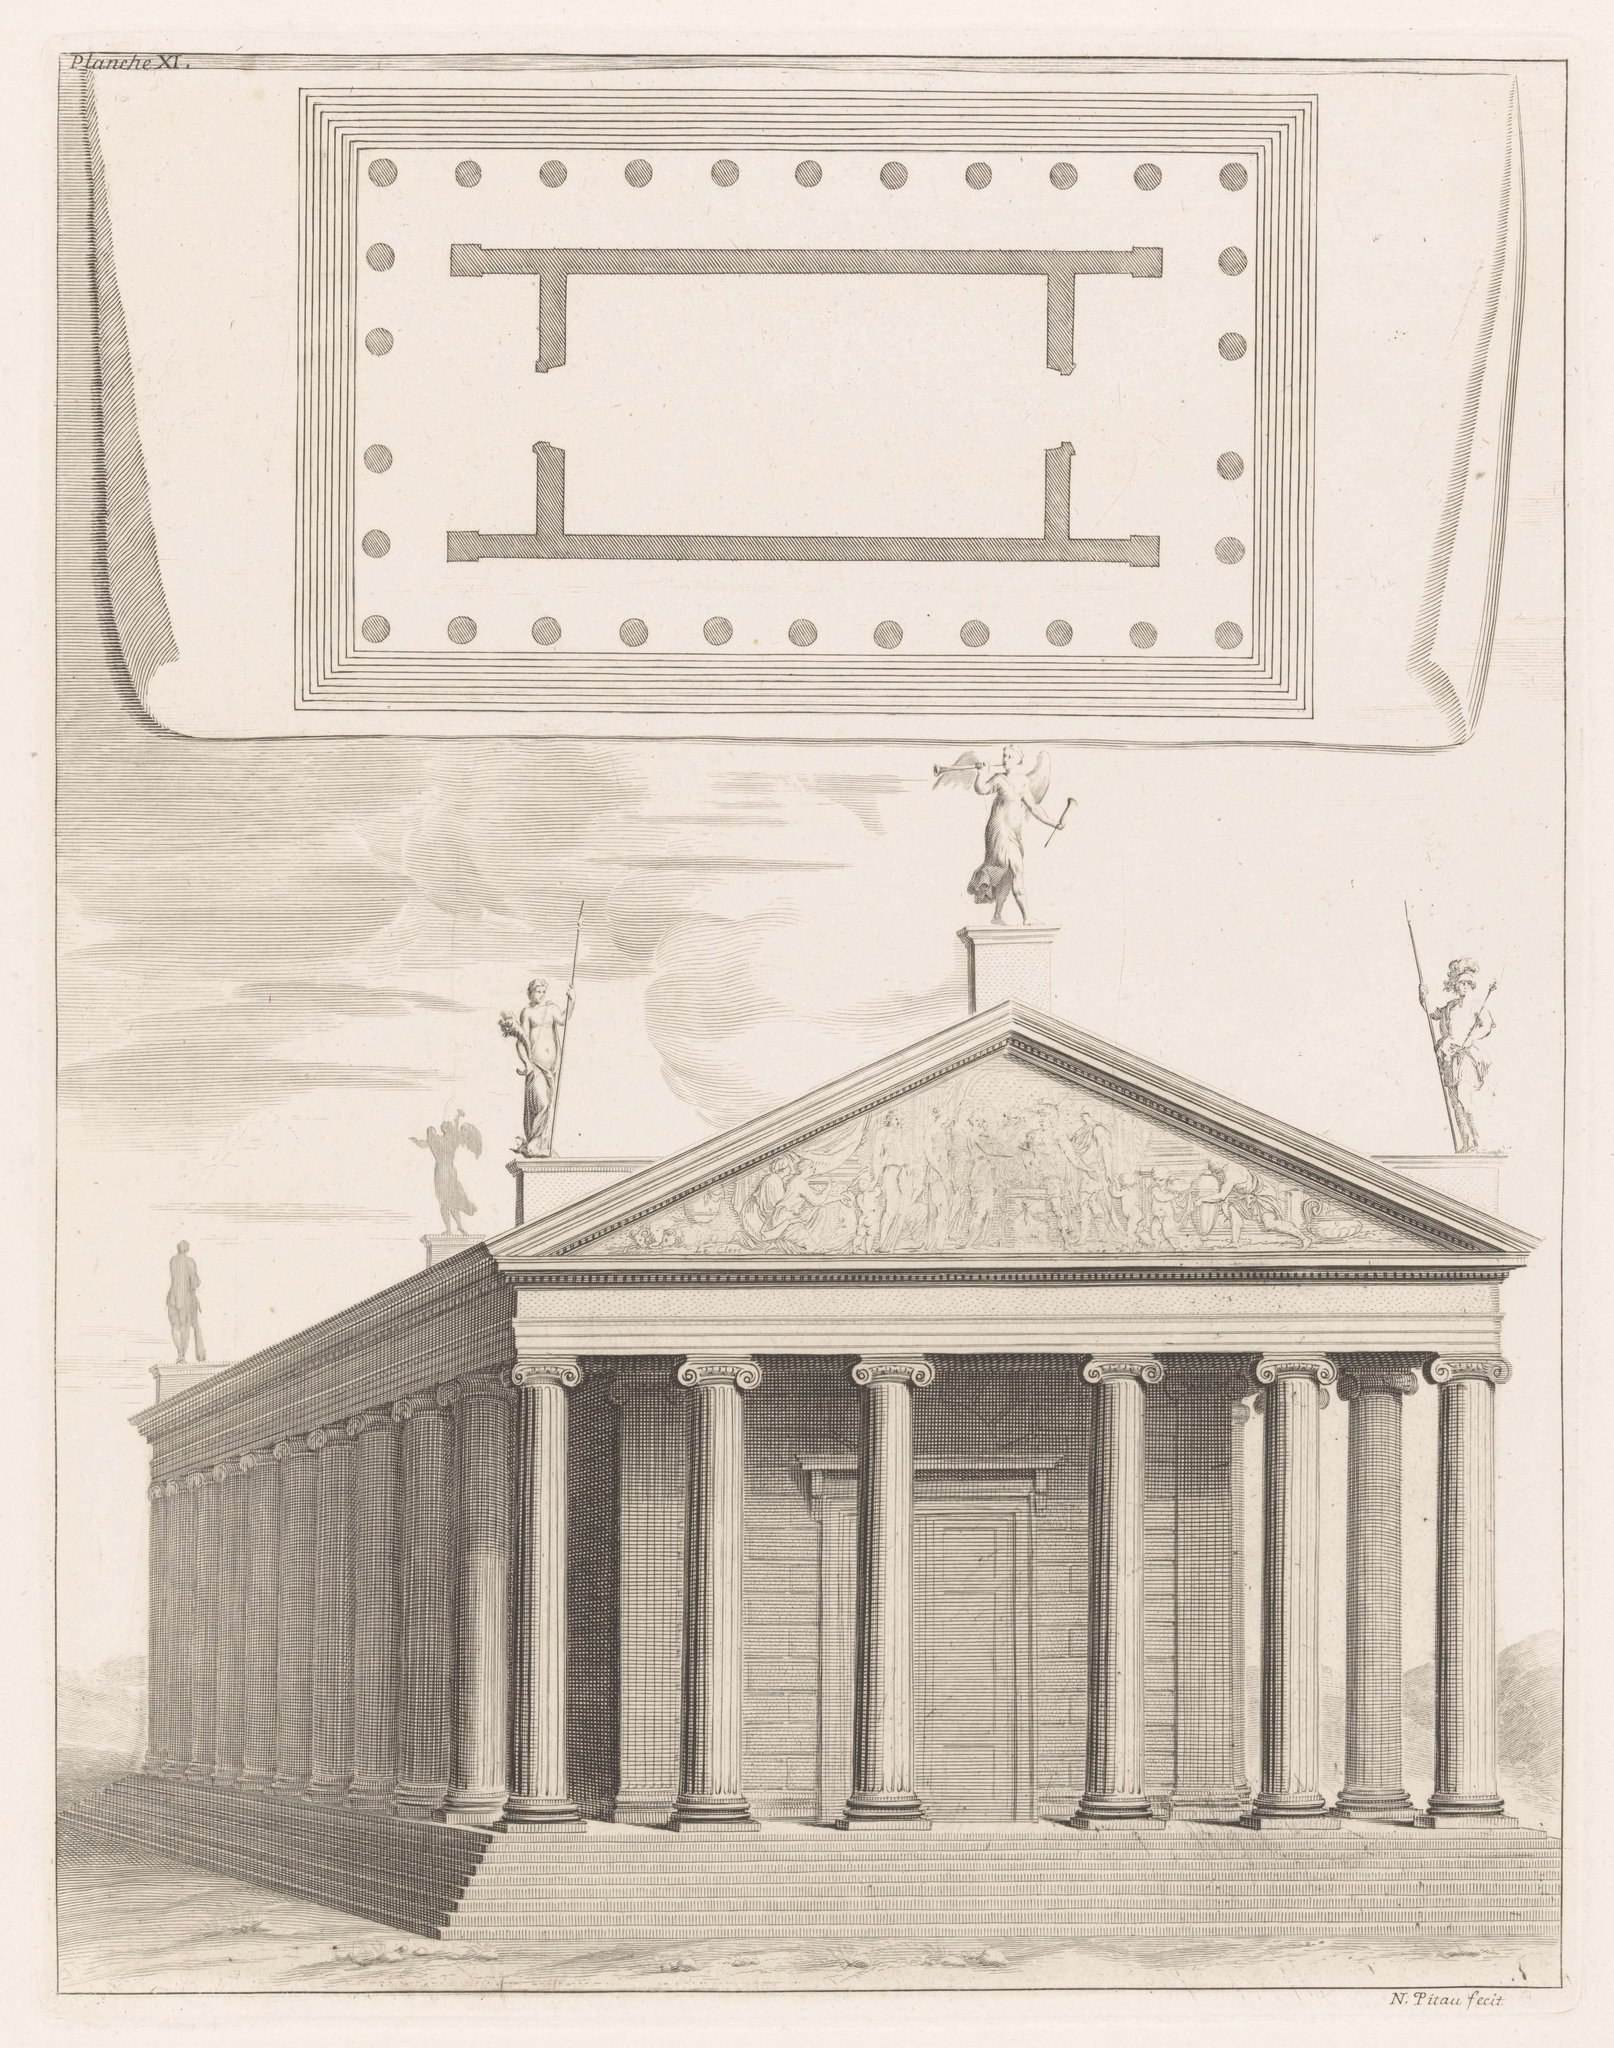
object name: book illustration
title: Tempel van Virtus en Honos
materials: paper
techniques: engraving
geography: paris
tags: virtus as roman personification, honos as roman personification, temple, shrine ~ roman religion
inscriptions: collector's mark: Lugt 2228, check stamp: Lugt 1695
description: Plattegrond en voor- en linkerzijde van de tempel van Virtus en Honos. De tempel is een peripteros met Ionische zuilen. Aan voor- en achterzijde van de tempel drie sculpturen boven het fronton met links Honos, in het midden Fama en rechts Virtus. Planche XI.